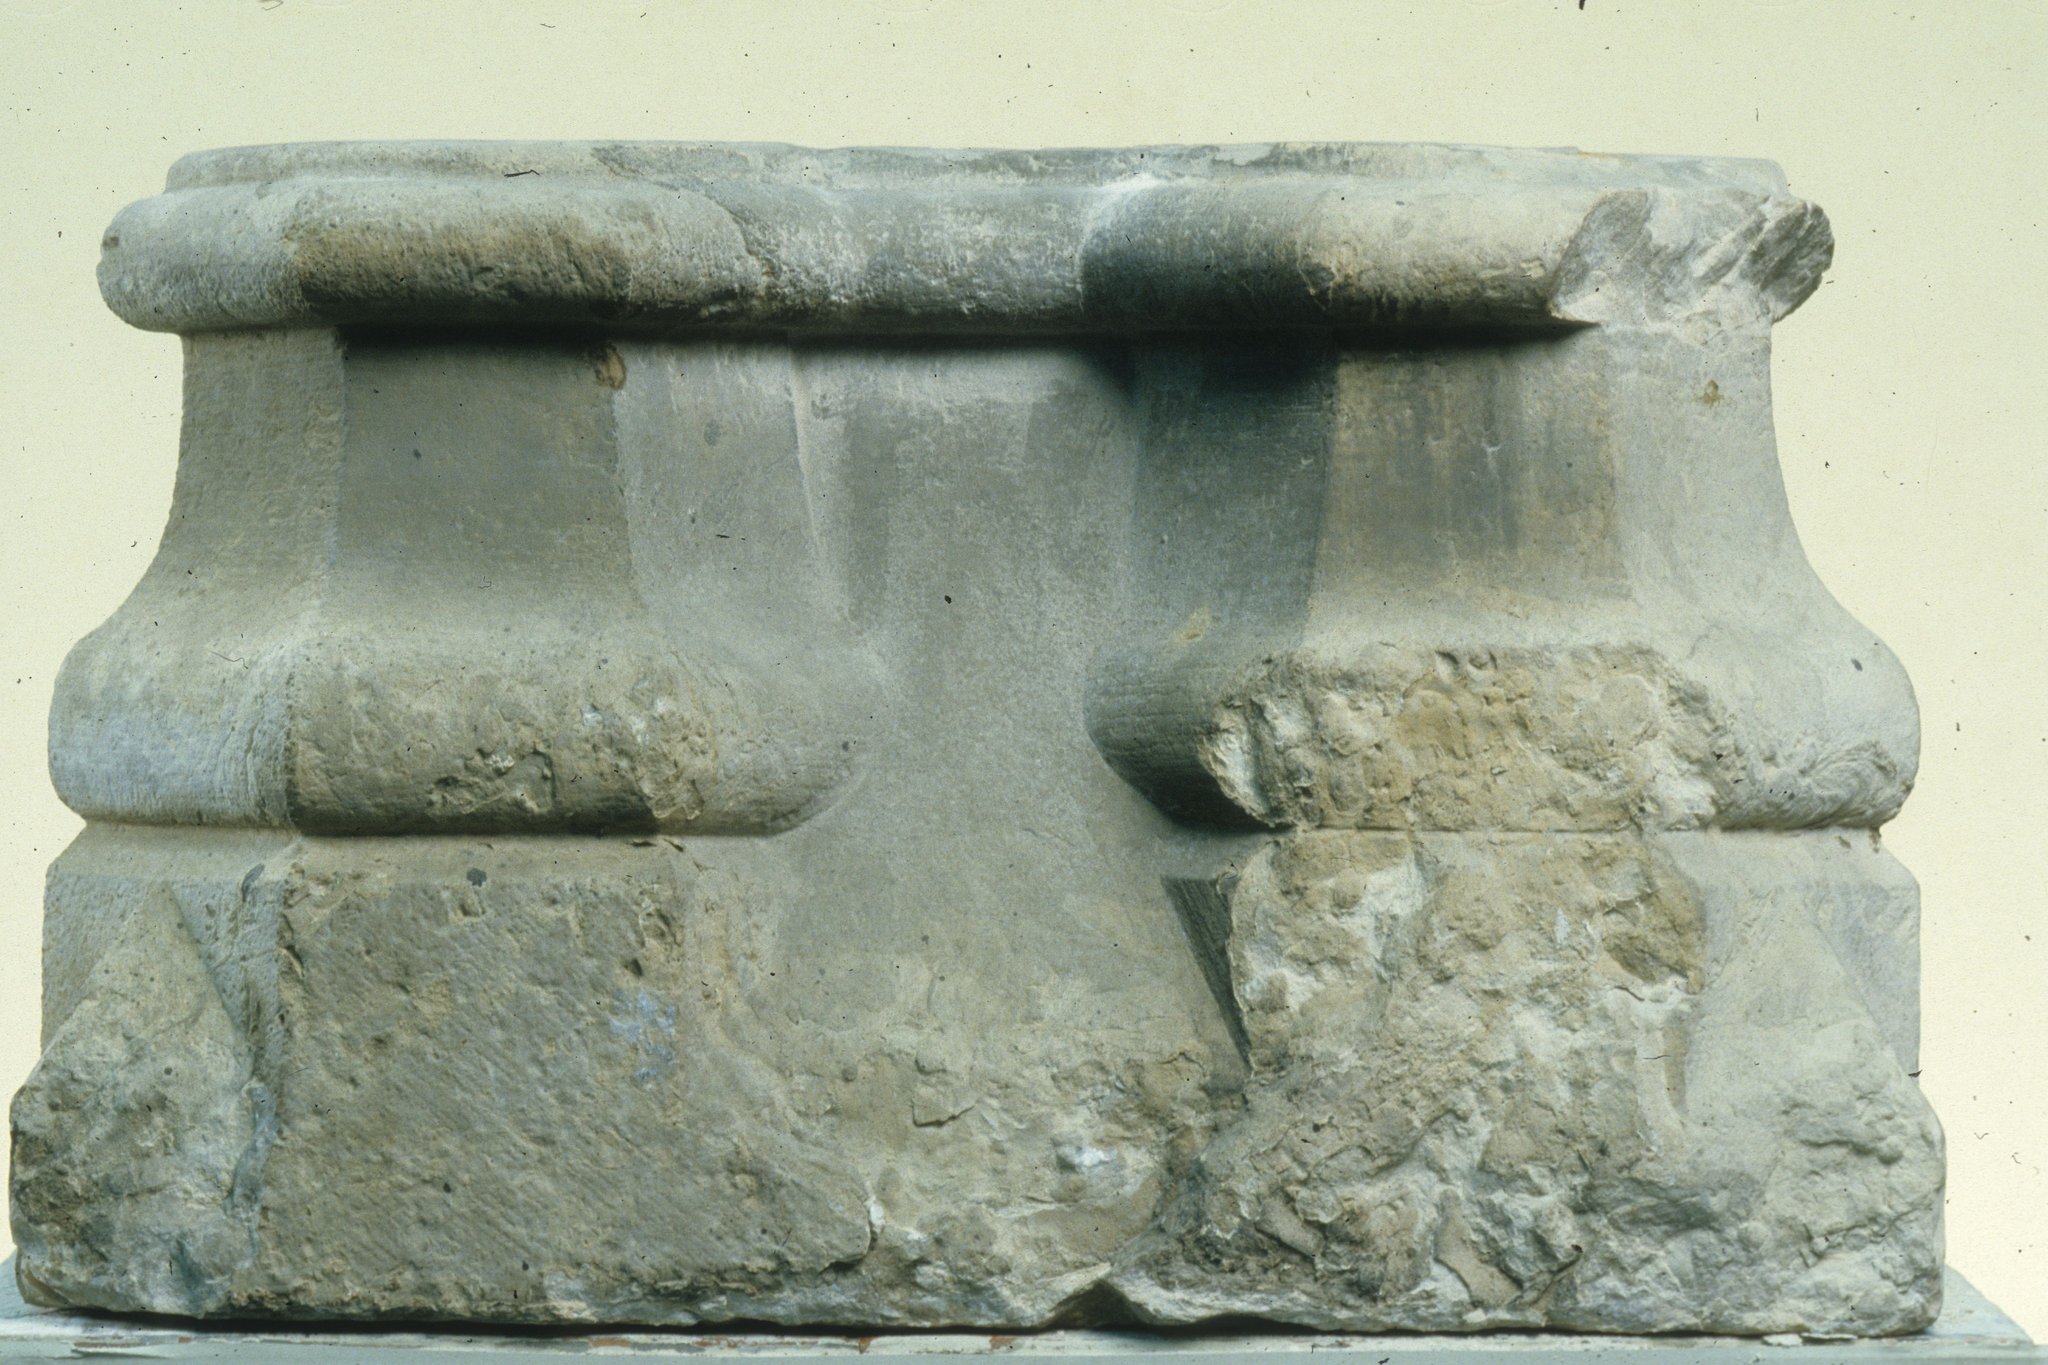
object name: base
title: Double Column Base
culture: french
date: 1467-1500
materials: marble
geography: france